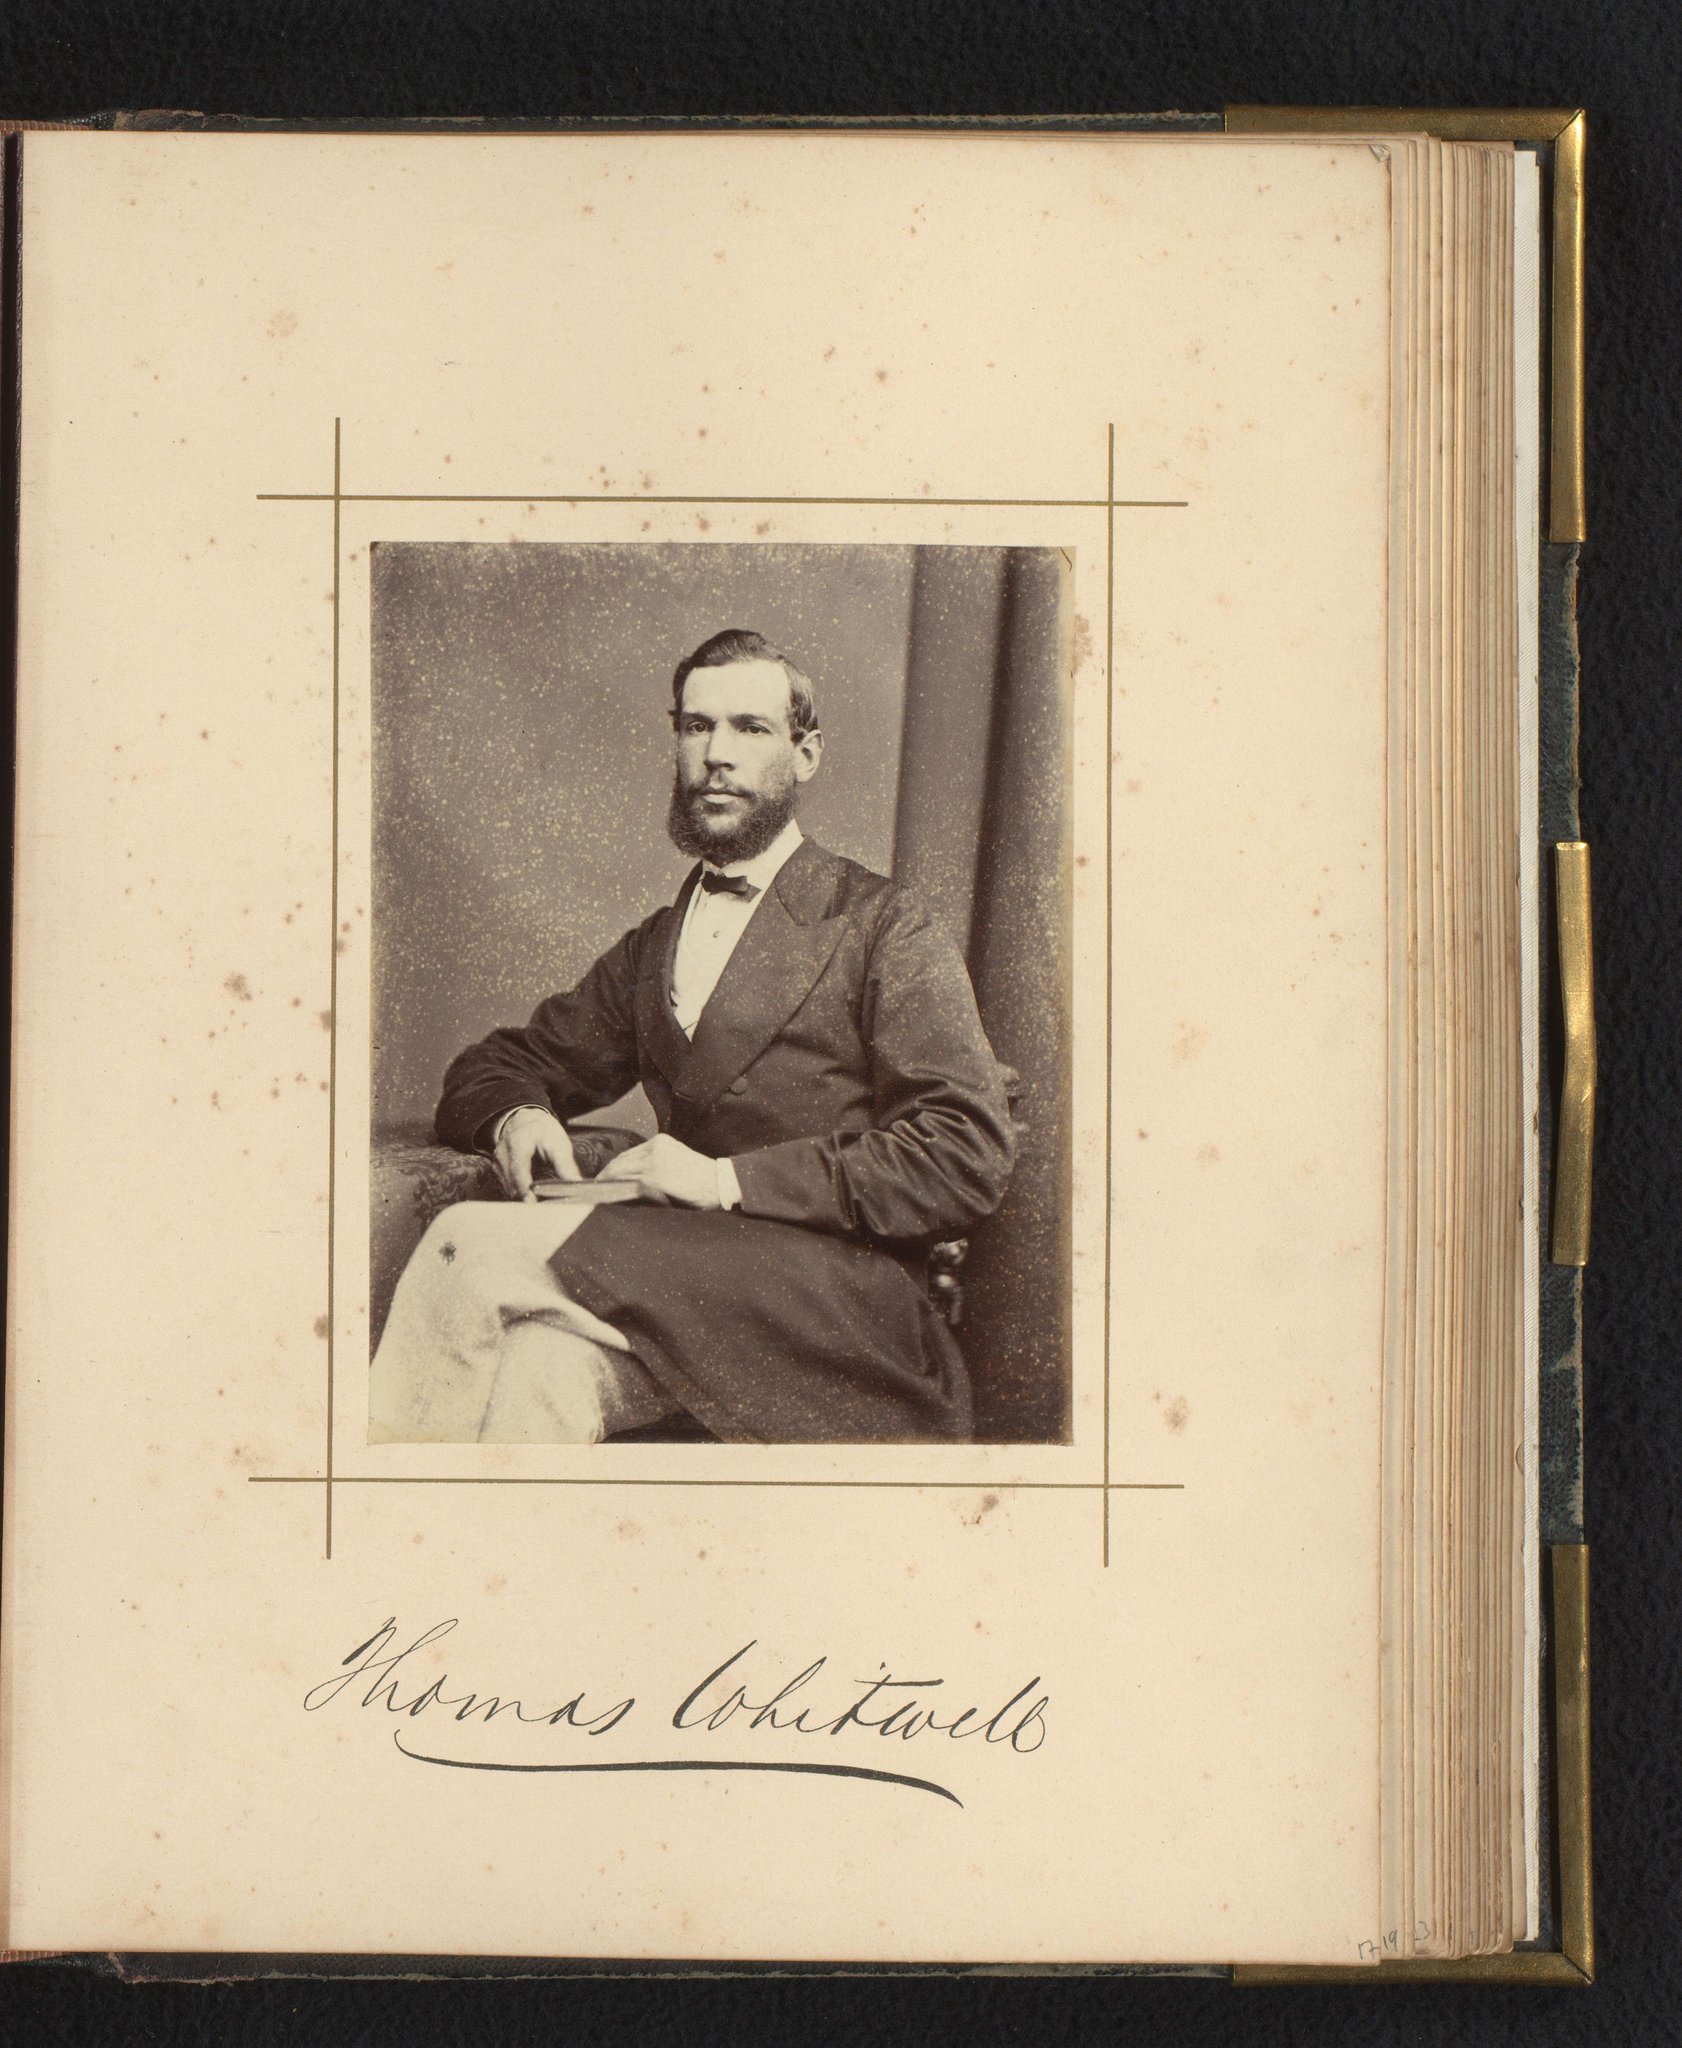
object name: photograph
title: Portret van een zittende man, mogelijk Thomas Lohitwell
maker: Anonymous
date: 1866-1871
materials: photographic support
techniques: albumen print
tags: sitting figure, historical persons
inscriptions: name: ‘Thomas [Lothitwell]’